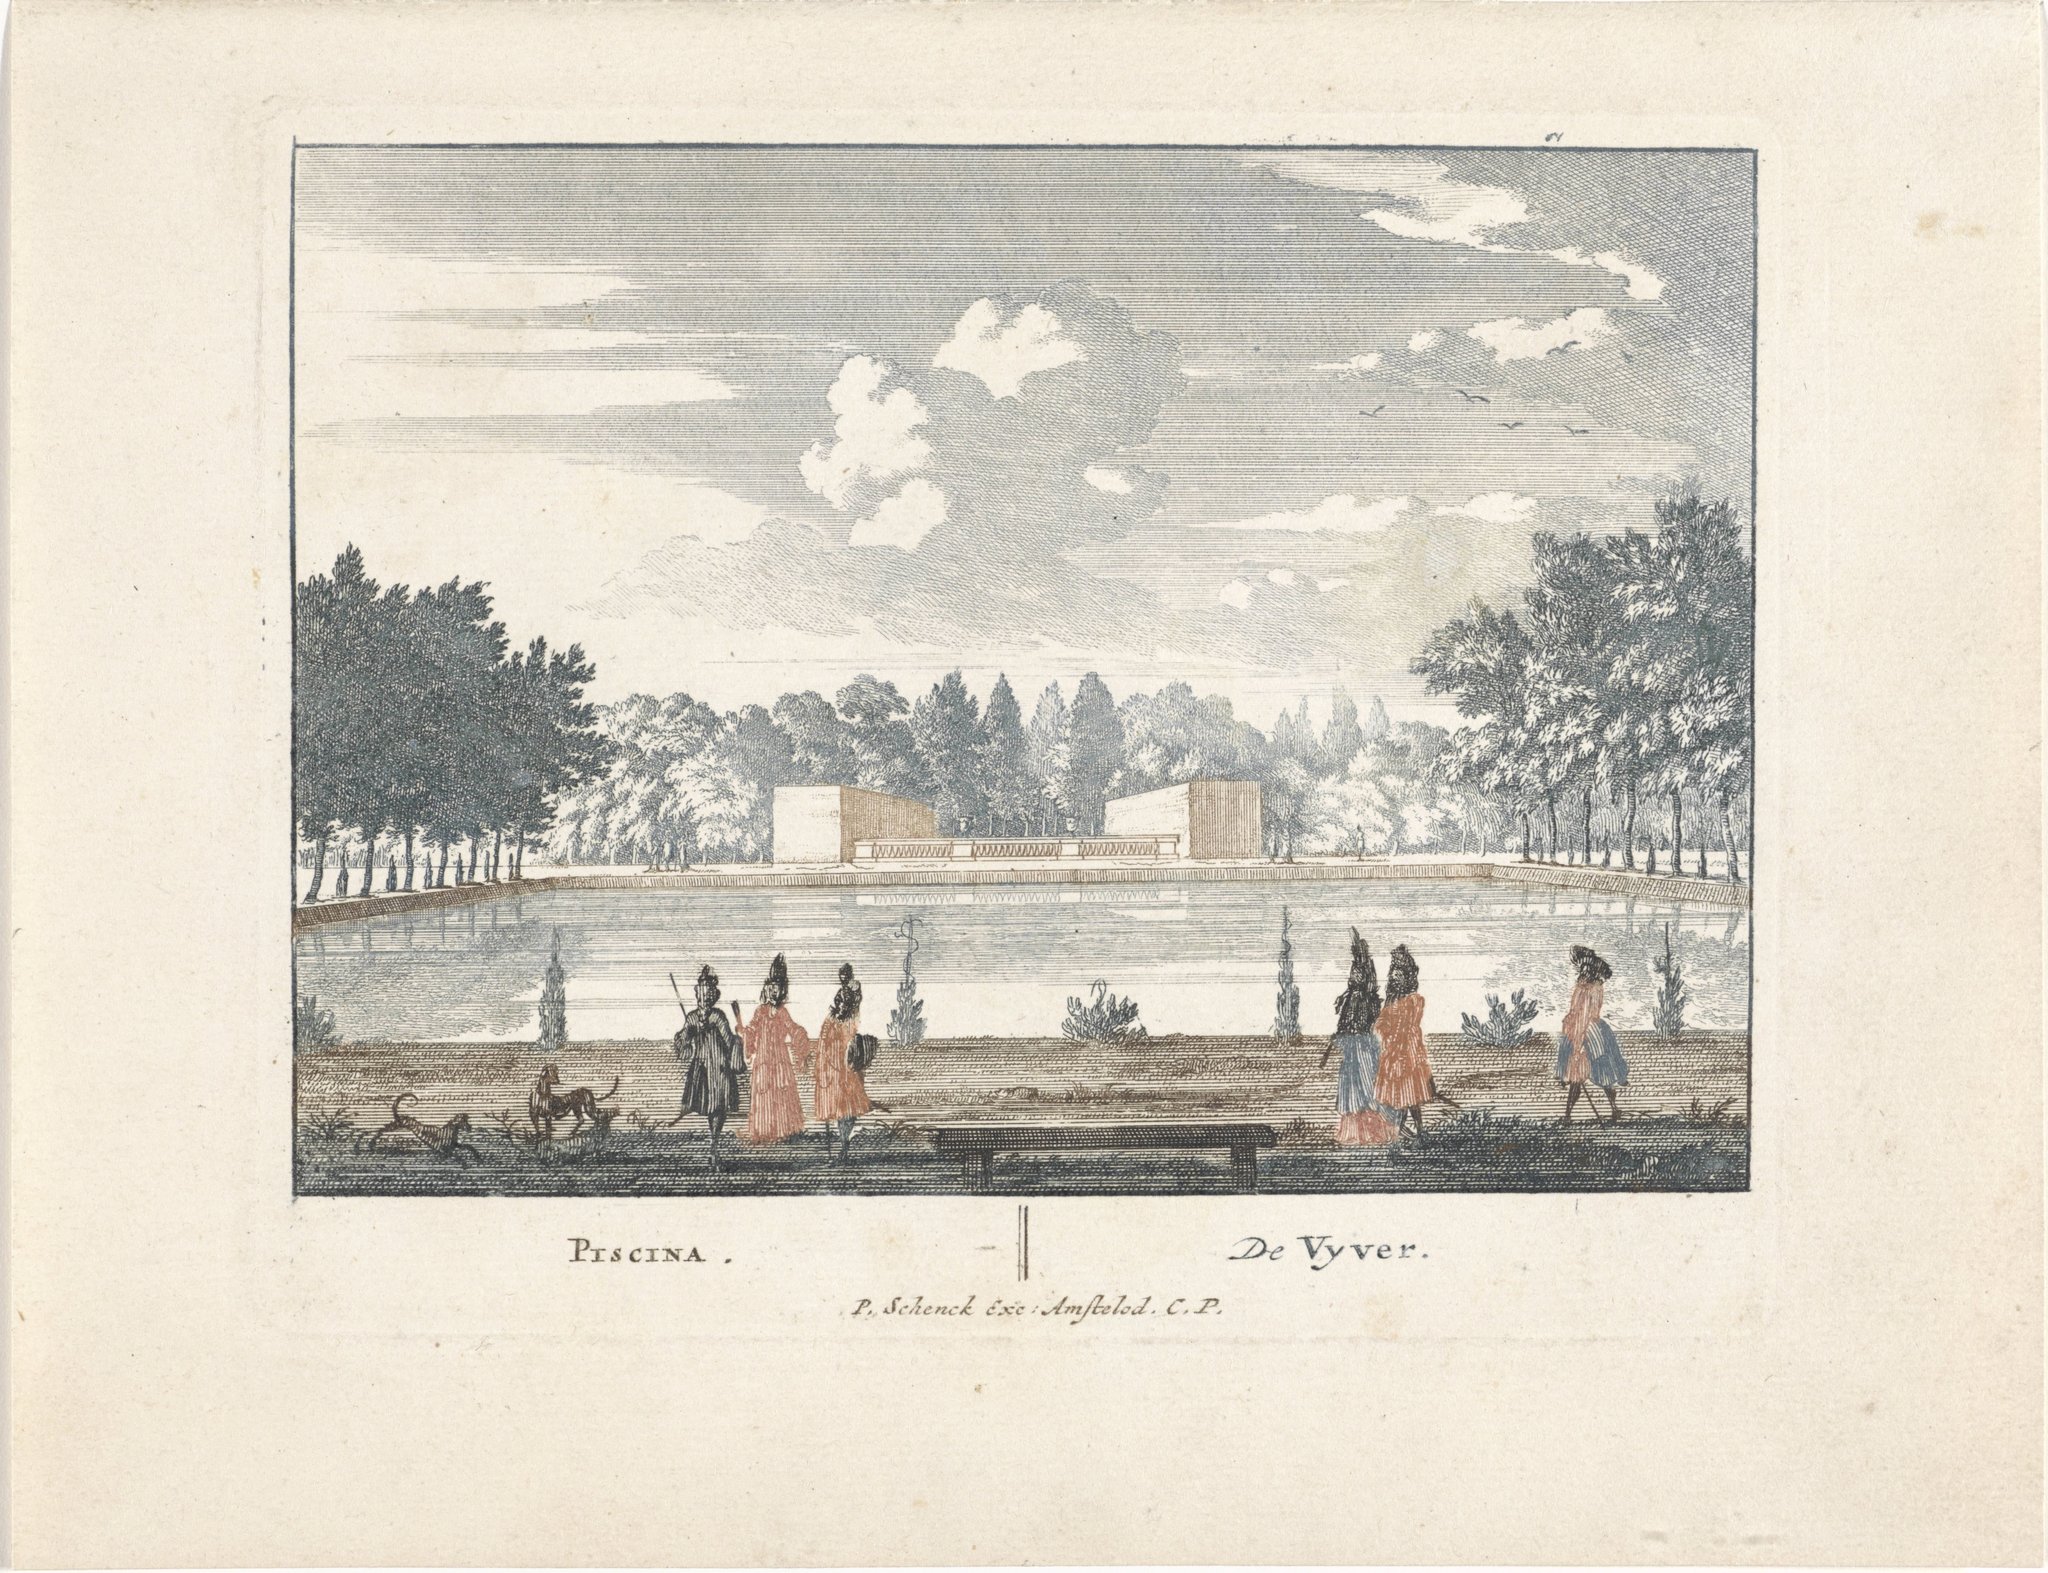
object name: print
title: Vijver in de tuinen van Paleis Het Loo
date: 1694-1697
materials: paper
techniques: etching, hand coloring, lithography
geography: amsterdam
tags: french or architectonic garden; formal garden, garden pond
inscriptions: collector's mark: Lugt 2228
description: Prent uit een serie van 71 prenten met Rijnlandschappen, gezichten op vorstelijke paleizen en stadsgezichten uit Den Haag en Amsterdam.